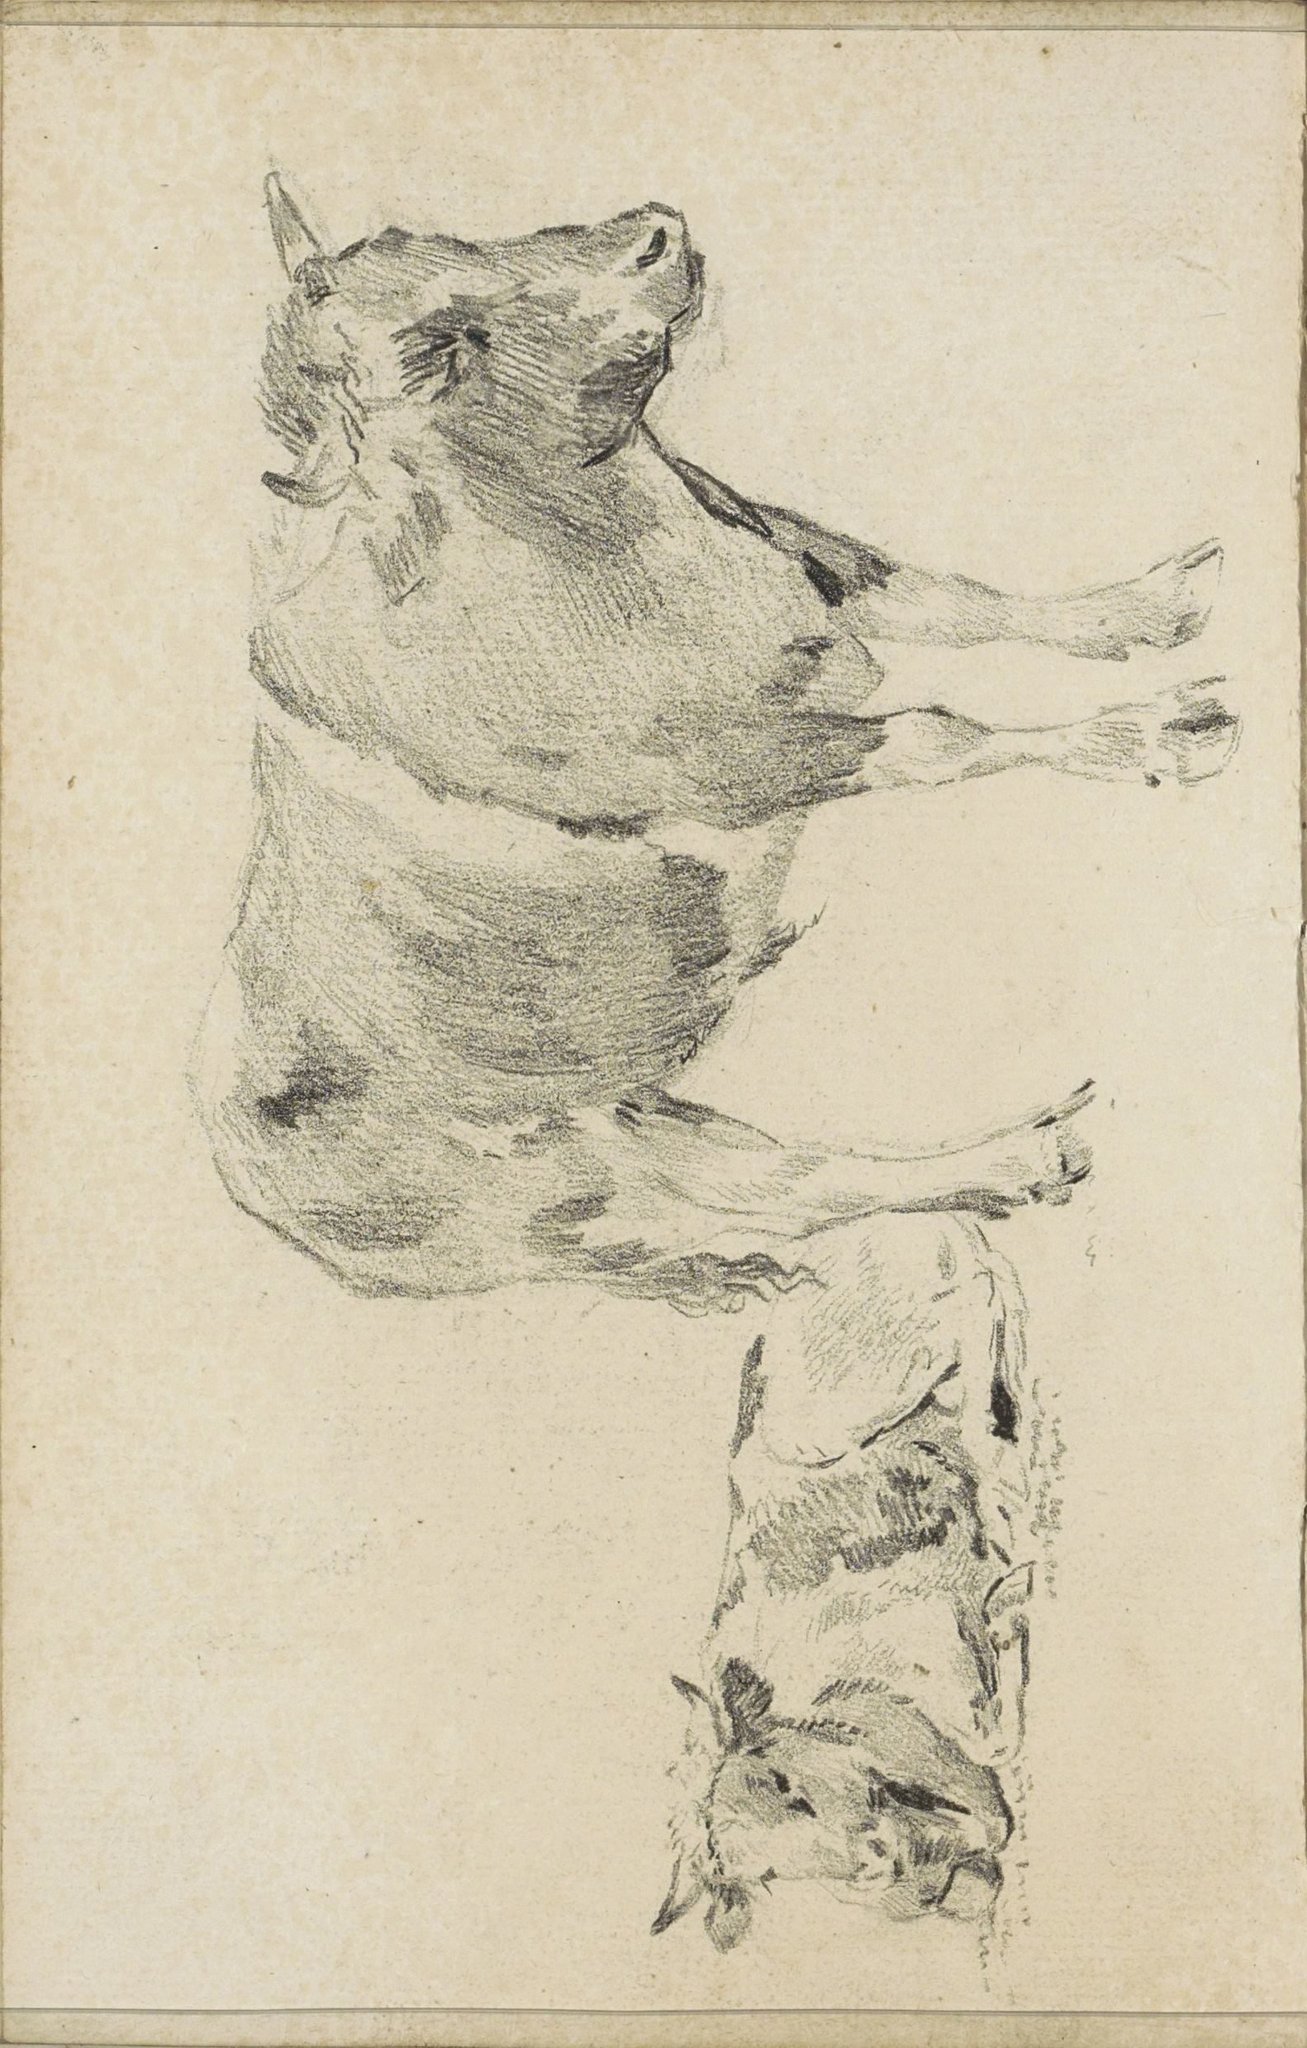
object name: sketchbook leaf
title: Staande en liggende koe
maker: jacob perkois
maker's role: draughtsman, print maker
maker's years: 1756-1804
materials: paper, pencil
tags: cow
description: Bladzijde 64 uit een schetsboek met 78 bladzijden.